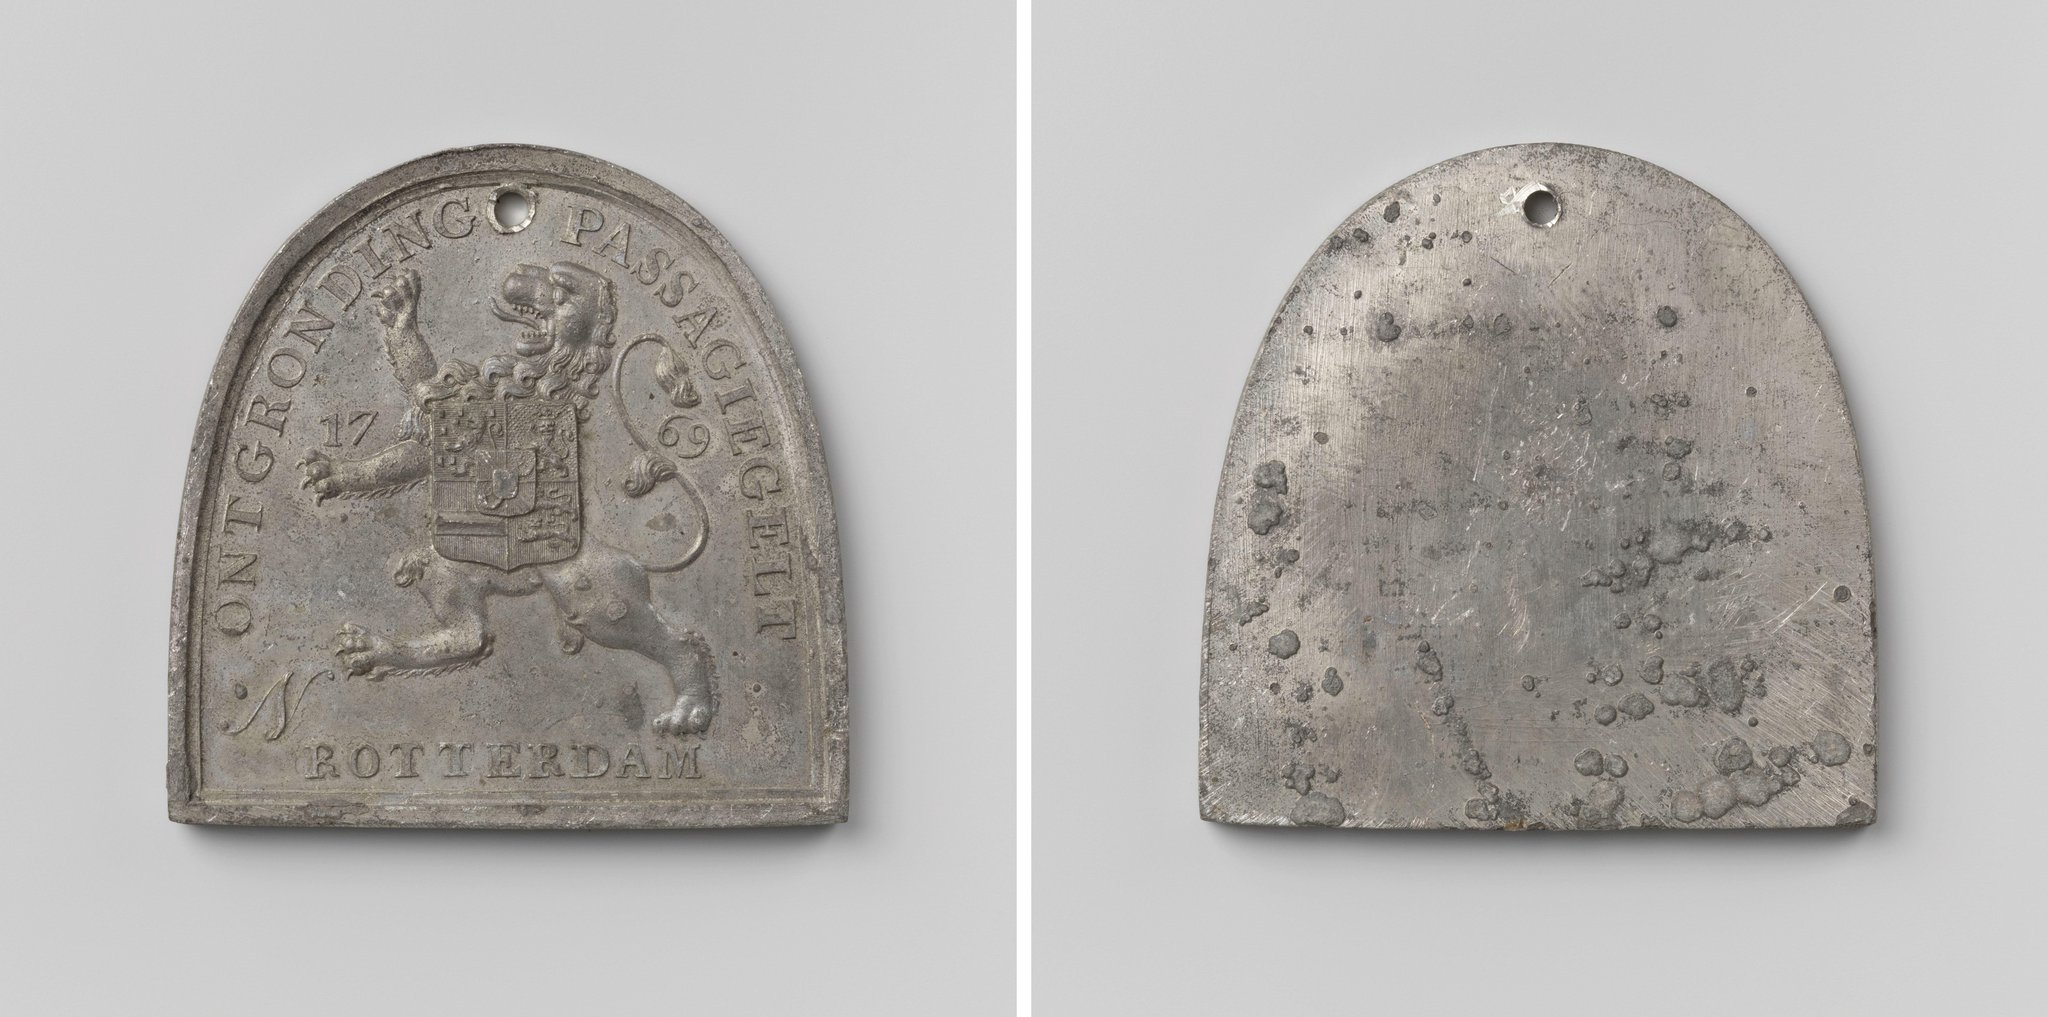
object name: ontgrondingspenning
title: Ontgronding te Rotterdam, penning bedoeld als bewijs voor turfdragers, -vullers of -tonners om turf in te mogen voeren uit de nieuw ontgronde venen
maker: Anonymous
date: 1769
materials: lead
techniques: casting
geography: rotterdam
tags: rotterdam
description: Eenzijdige loden penning met ronde boven- en rechthoekige onderzijde, en gat erin. Voorzijde: staande leeuw met wapenschild op borst tussen jaartal binnen omschrift. Keerzijde: blanco.